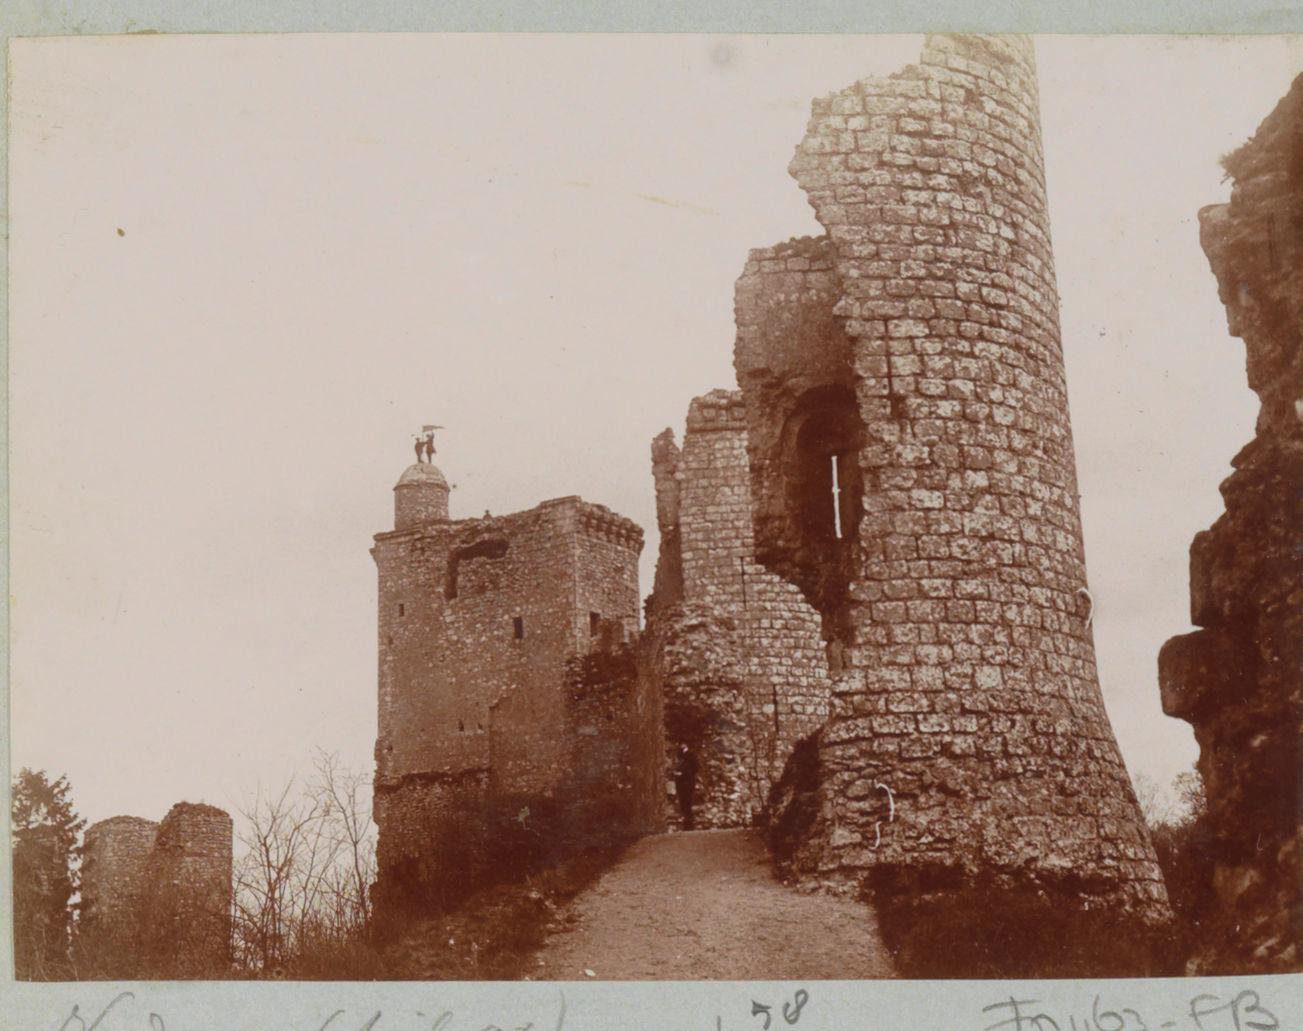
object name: photograph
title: Kasteelruïne in Vendôme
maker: delizy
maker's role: manufacturer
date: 1804-1898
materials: paper, photographic support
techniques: gelatin silver print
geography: vendôme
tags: ruin of a dwelling, house, castle, etc.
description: Onderdeel van Fotoalbum van een Franse amateurfotograaf met opnames van uitstapjes in Frankrijk, Spanje, België, Luxemburg en Nederland, de eerste automobielen en autoraces.